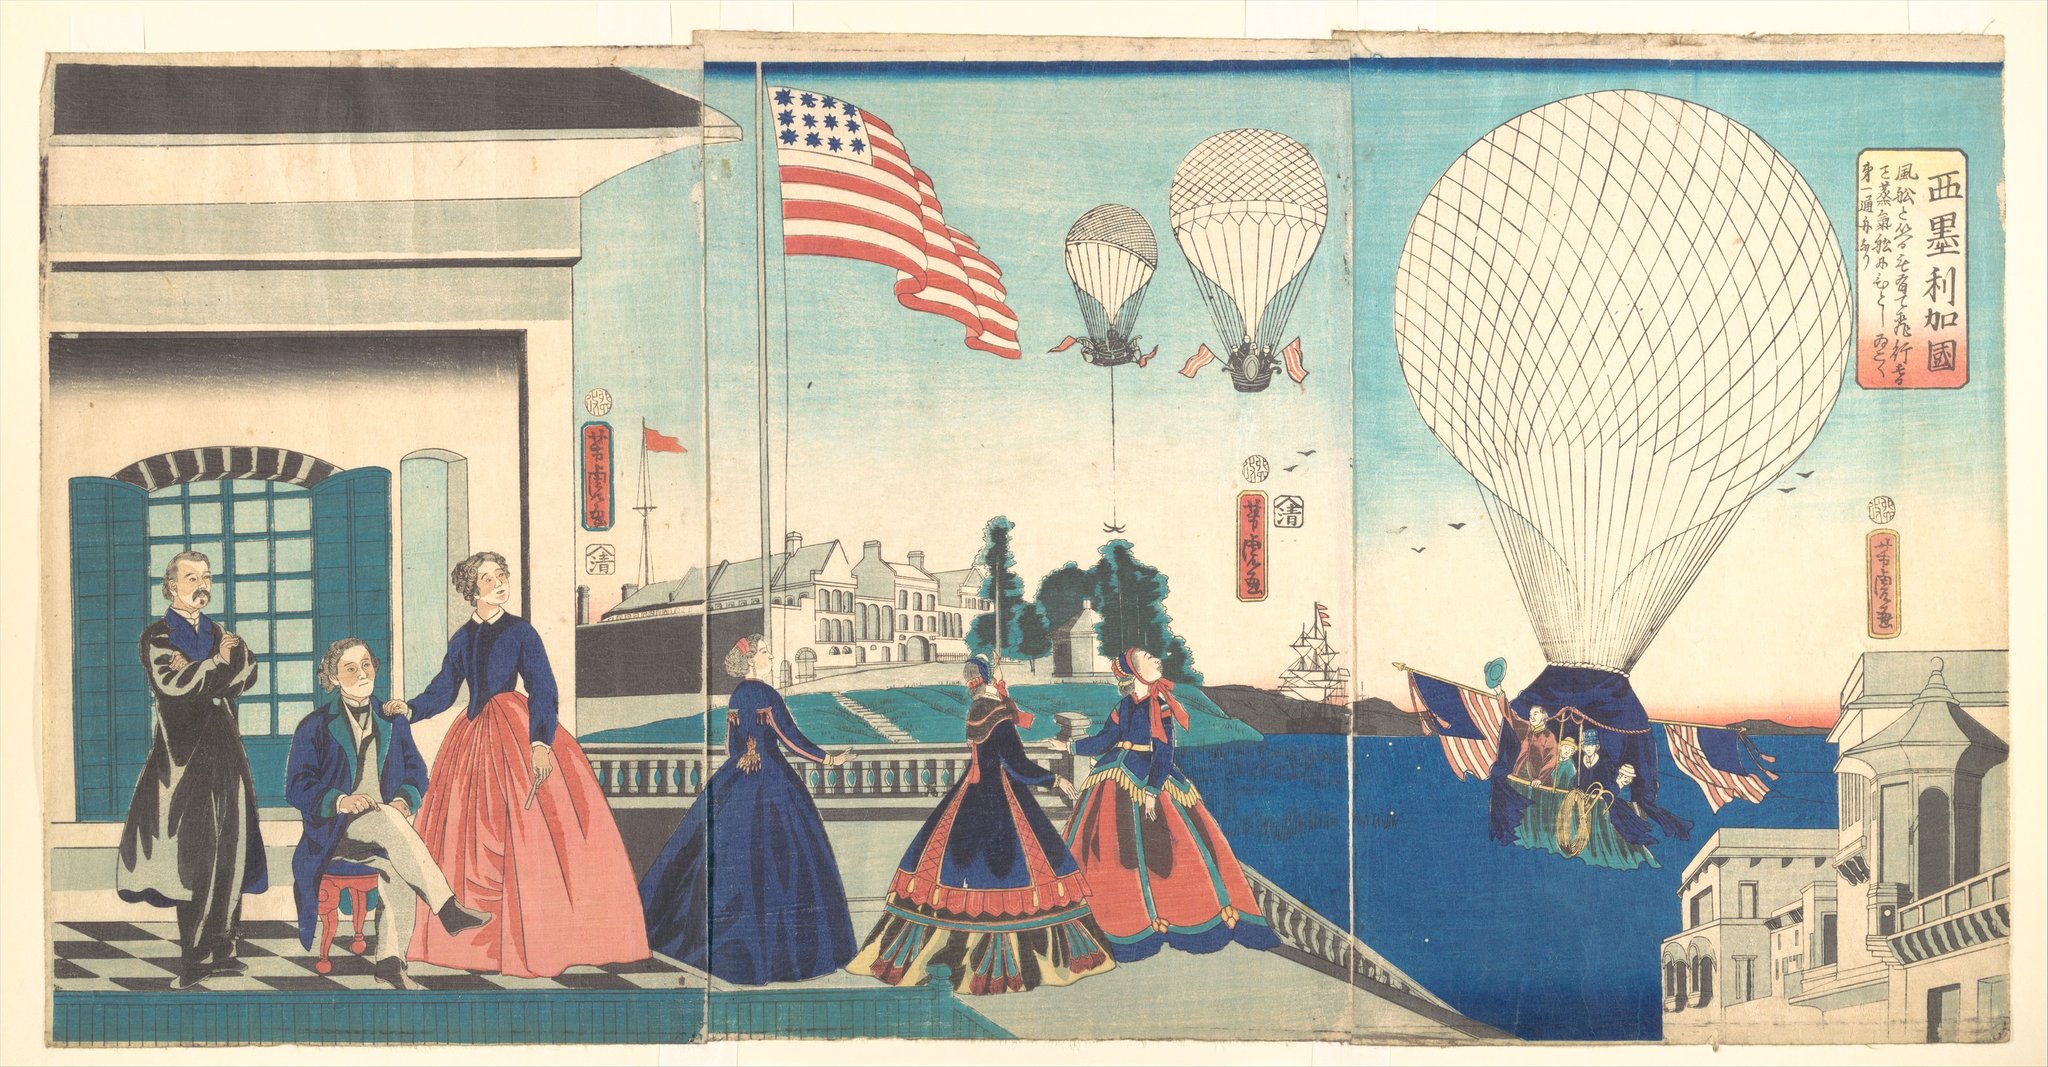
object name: print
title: “America”: Enjoying Hot Air Balloons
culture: japanese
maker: utagawa yoshitora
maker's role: artist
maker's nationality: japanese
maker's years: 1845-1880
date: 1867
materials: ink, paper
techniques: woodblock print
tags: buildings,men,women,flags,hot air balloons